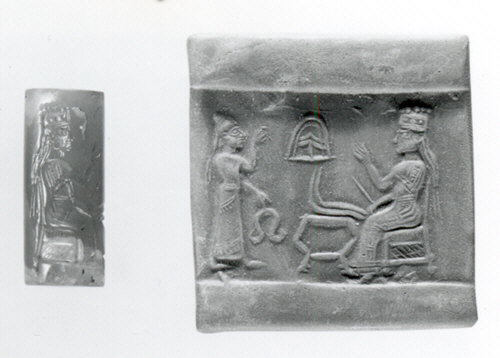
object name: cylinder seal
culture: assyrian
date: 1300-1201 BCE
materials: gemstone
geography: mesopotamia